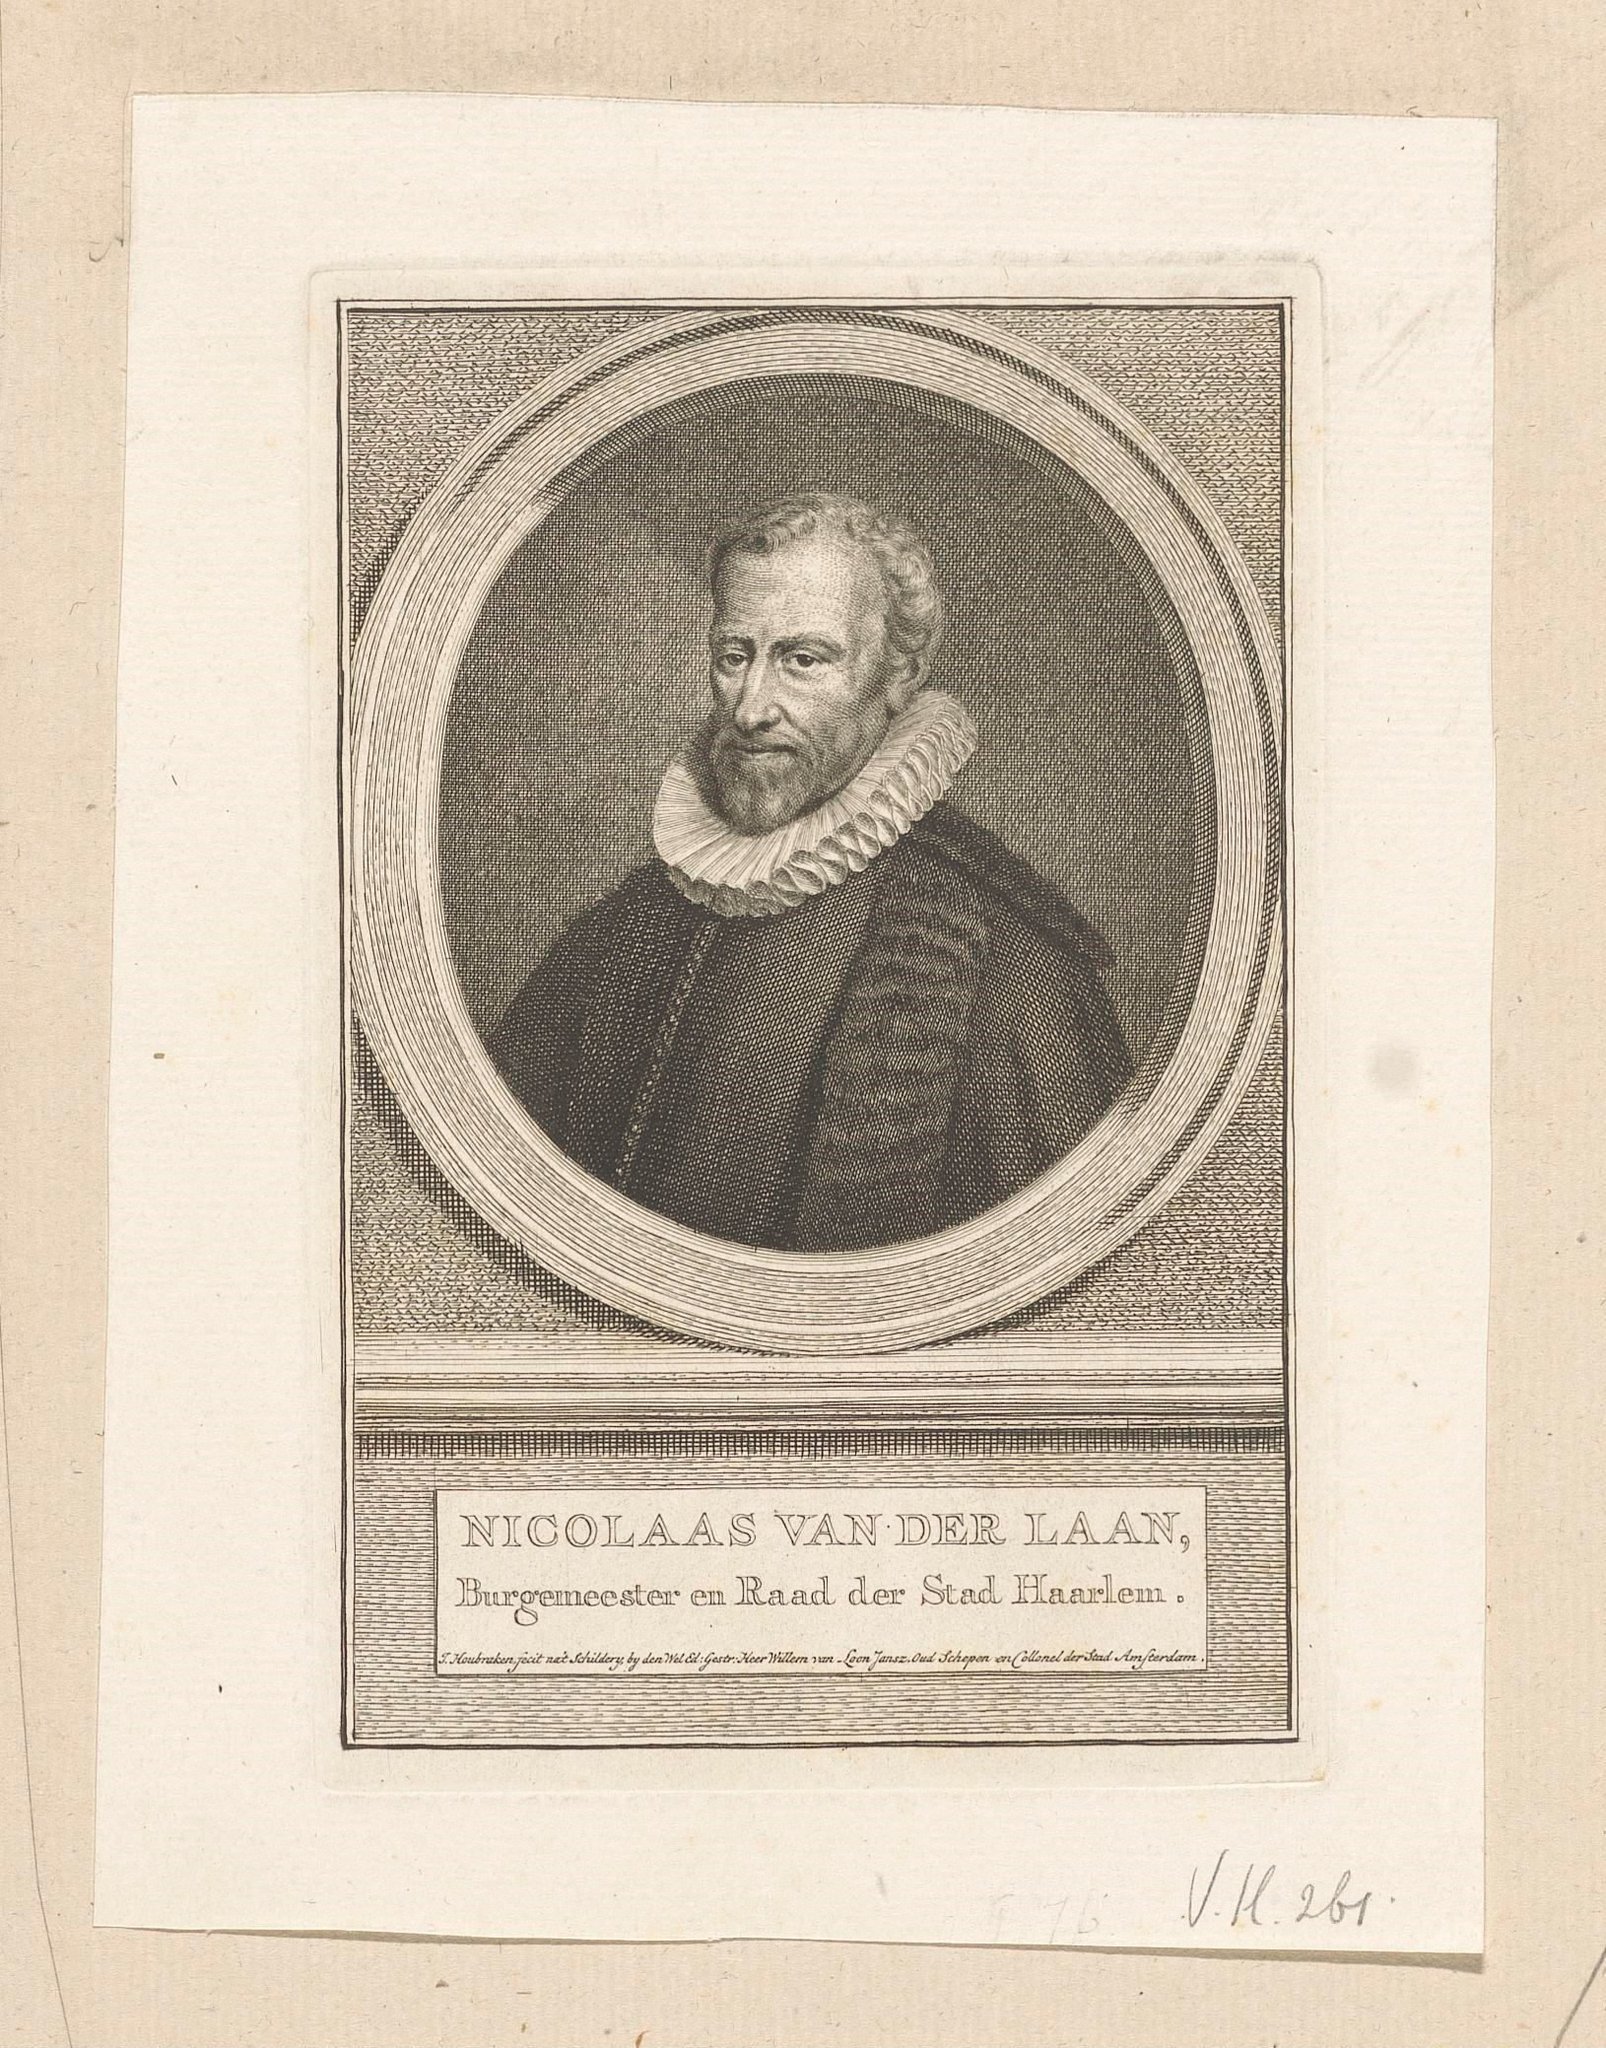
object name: print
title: Nicolaas van der Laan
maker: jacob houbraken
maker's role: draughtsman, print maker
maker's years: 1698-1780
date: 1749-1780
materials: paper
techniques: engraving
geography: amsterdam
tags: haarlem, enkhuizen, mayor, historical persons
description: Deze prent is oorspronkelijk bedoeld als aanvulling op Jan Wagenaars ‘Vaderlandsche historie’* en was zo vanaf 1796 verkrijgbaar bij Johannes Allart te Amsterdam. Voor de advertentie waarin Allart de 60 portretten en 7 platen, allen gegraveerd door Houbraken, ter aanvulling op Wagenaars ‘Vaderlandsche historie’ aanbiedt, zie RP-P-OB-77.766. *Van dit werk zijn in de achttiende eeuw meerdere uitgaves verschenen, zoals: Wagenaar, Jan. Vaderlandsche historie, vervattende de geschiedenissen der Vereenigde Nederlanden (…). 21 delen. Amsterdam: Isaak Tirion, 1749-1759. Wagenaar, Jan. Vaderlandsche historie, vervattende de geschiedenissen der nu Vereenigde Nederlanden (…). 21 delen. Amsterdam: weduwe Isaak Tirion, 1770. Wagenaar, Jan. Vaderlandsche historie, vervattende de geschiedenissen der nu Vereenigde Nederlanden (…). 21 delen. Amsterdam, Leiden, Dordrecht en Harlingen: P. Schouten e.a., 1782. Wagenaar, Jan. Vaderlandsche historie, vervattende de geschiedenissen der nu Vereenigde Nederlanden (…). 21 delen. Amsterdam: Johannes Allart, 1790-1796.